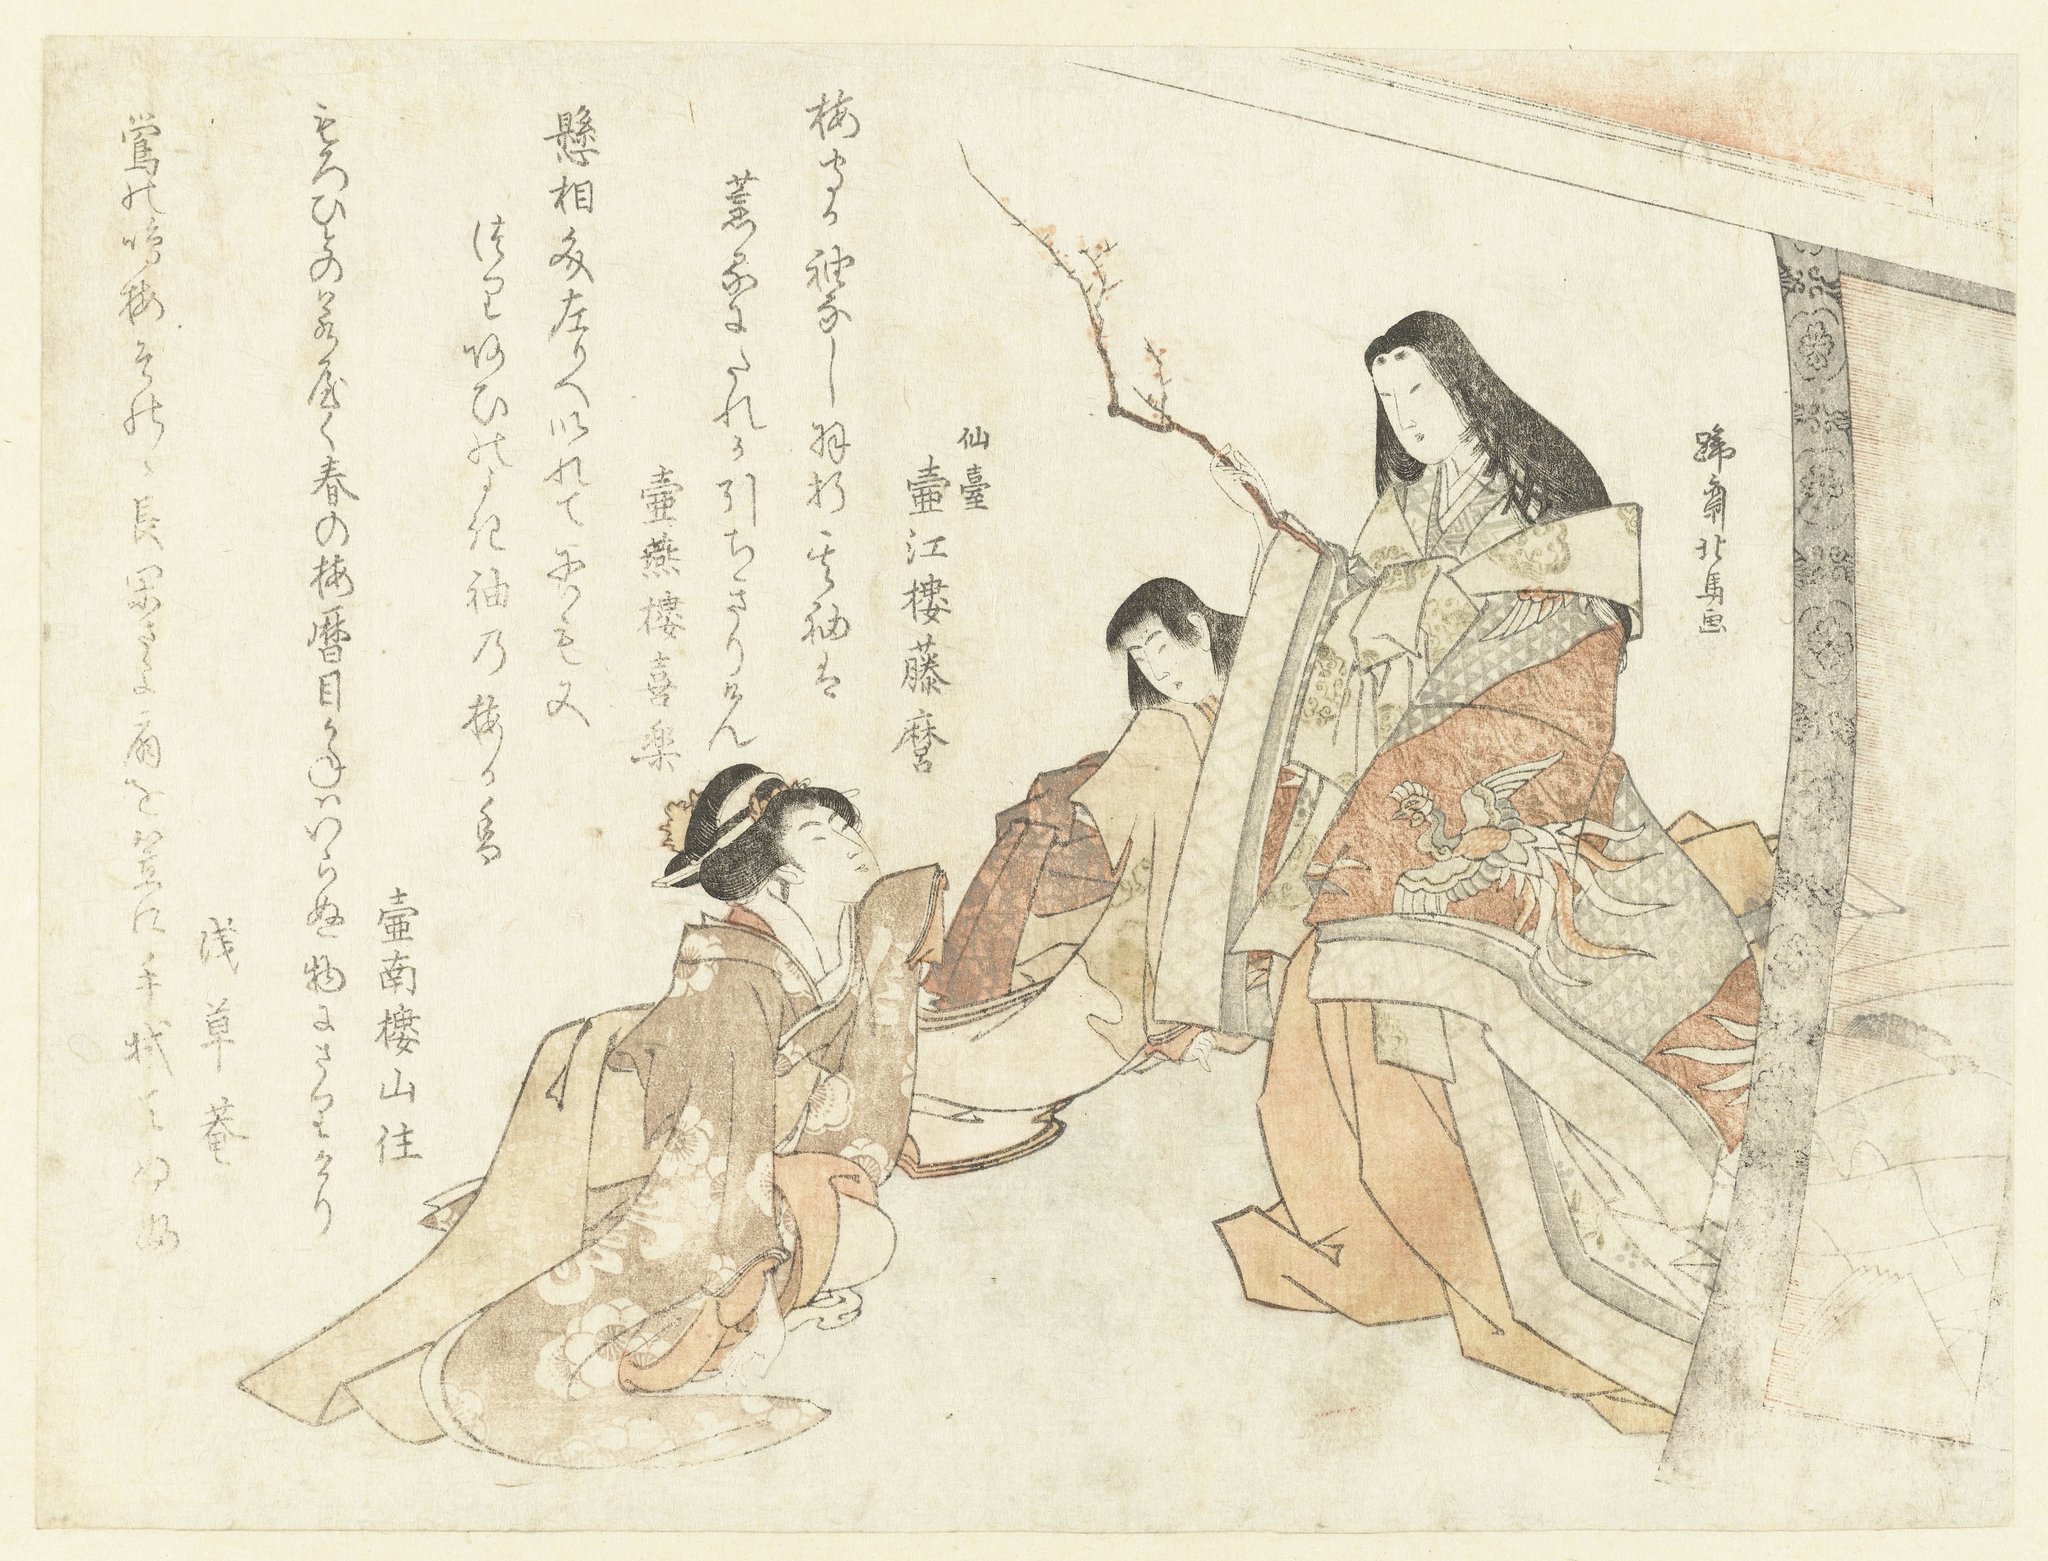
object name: surimono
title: Court Lady with Branch of Plum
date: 1810-1820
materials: paper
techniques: blind stamped, woodcut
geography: japan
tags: plants; vegetation, adult woman (+ three persons), maid ~ house personnel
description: Een surimono is een luxe uitgevoerde prent waarop beeld met één of meerdere gedichten gecombineerd is. Bij het drukken van een surimono werd vaak gebruik gemaakt van dikker papier, blinddruk en metaal pigmenten, zoals koper- en zilverpoeder. De prenten werden vaak in opdracht van dichters gemaakt en als exclusief geschenk aan vrienden en relaties gegeven.